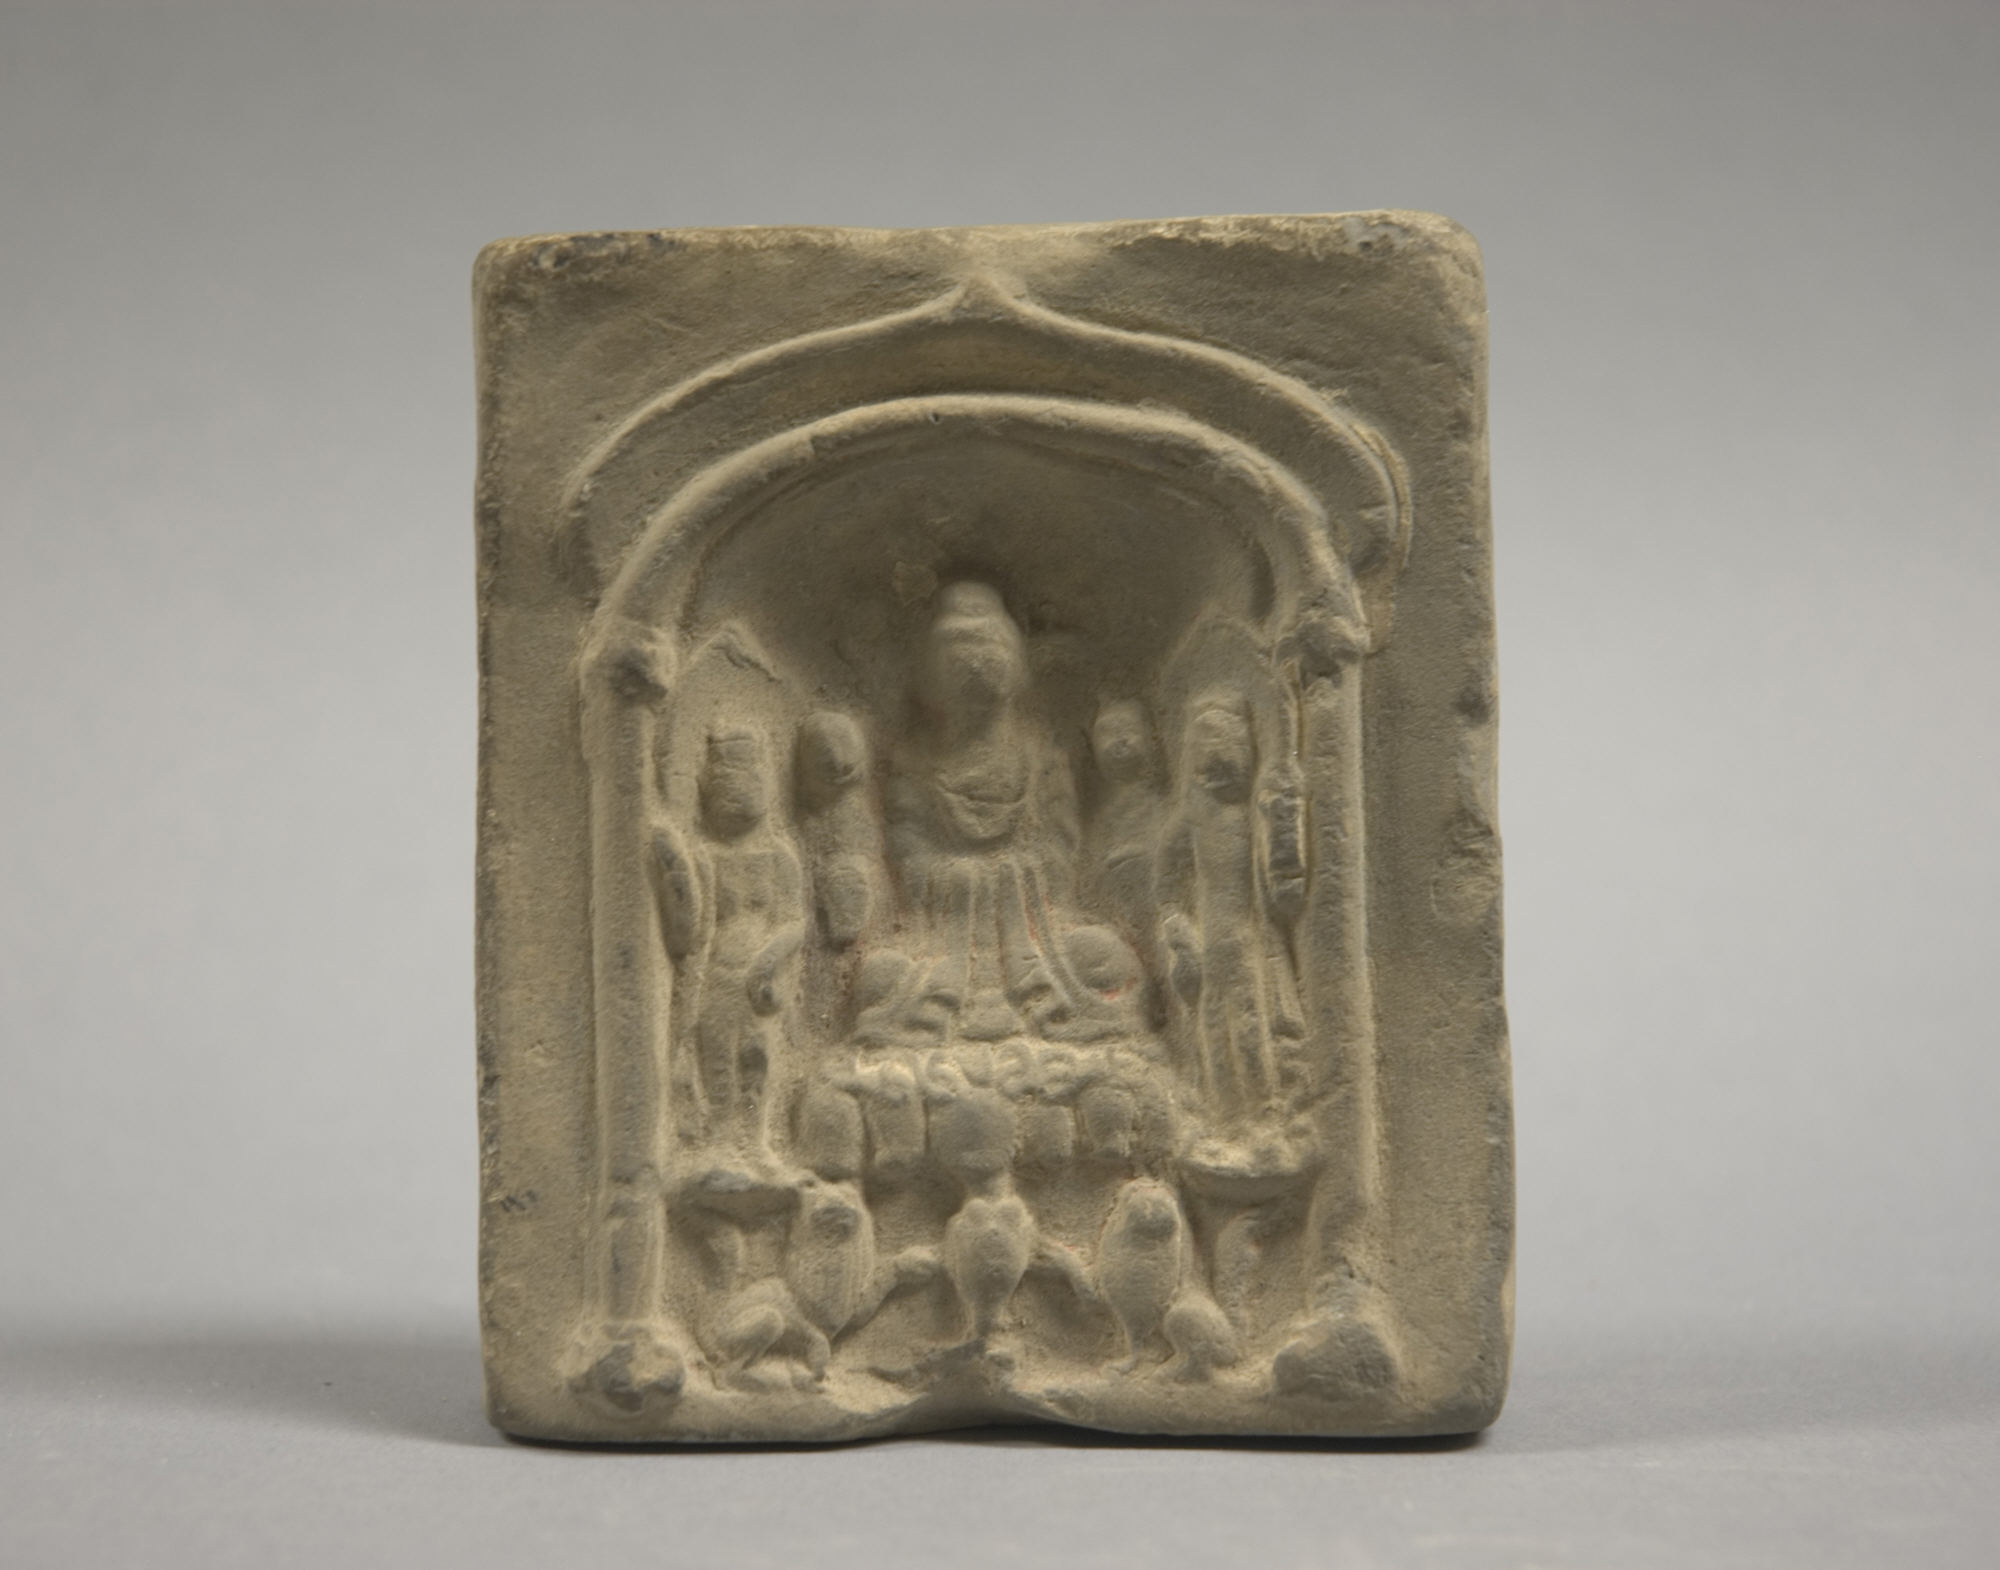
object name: votive tablet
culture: chinese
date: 501-600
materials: earthenware